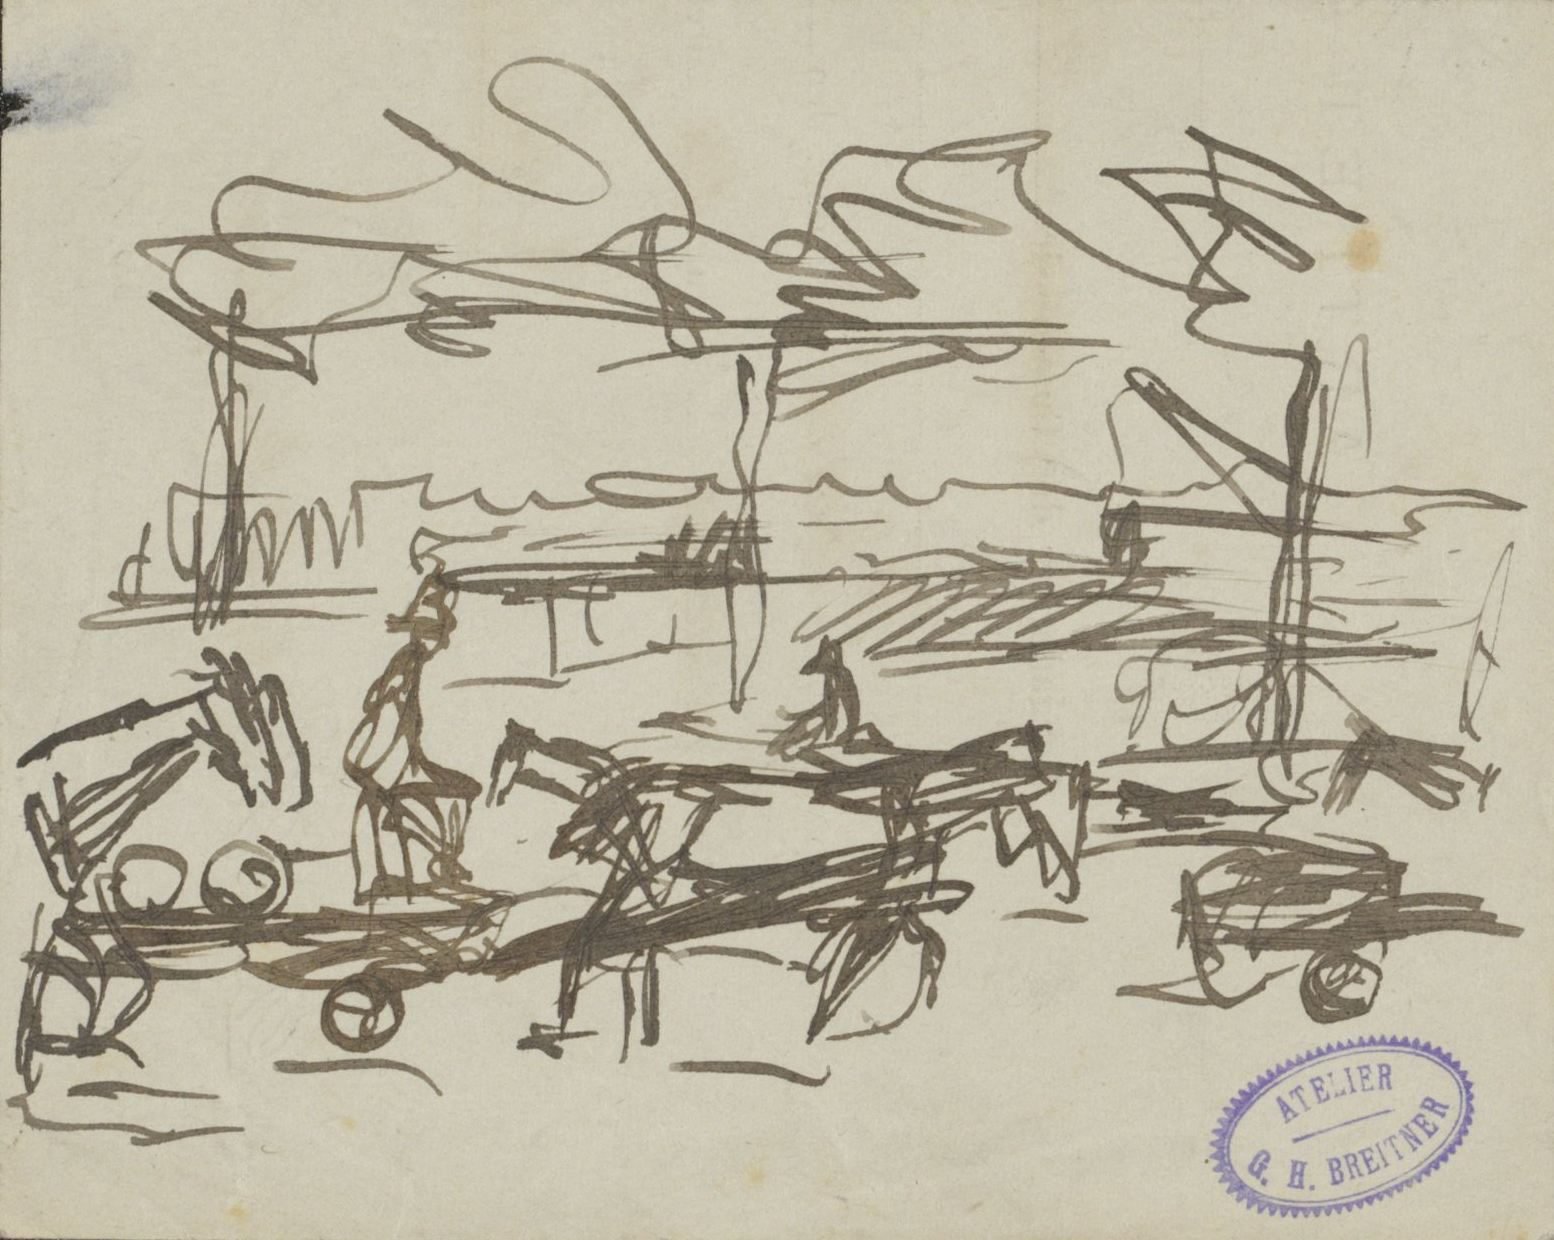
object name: drawing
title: Landschap met bereden artillerie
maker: george hendrik breitner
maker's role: draughtsman, painter, print maker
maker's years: 1857-1923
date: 1896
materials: ink, paper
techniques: pen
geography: the hague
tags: land forces (+ artillery), landscapes in the temperate zone, horse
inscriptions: collector's mark: Lugt 2228, annotation: ‘Arti et A/ Vergadering der Commissie [doorgestreept] van Be/ op Woensdag, den/ des middags ten 31/2 ure./ Med/ Den Heere G.H. Breitner/ s.s.t.t.’, workshop stamp: Lugt 291d